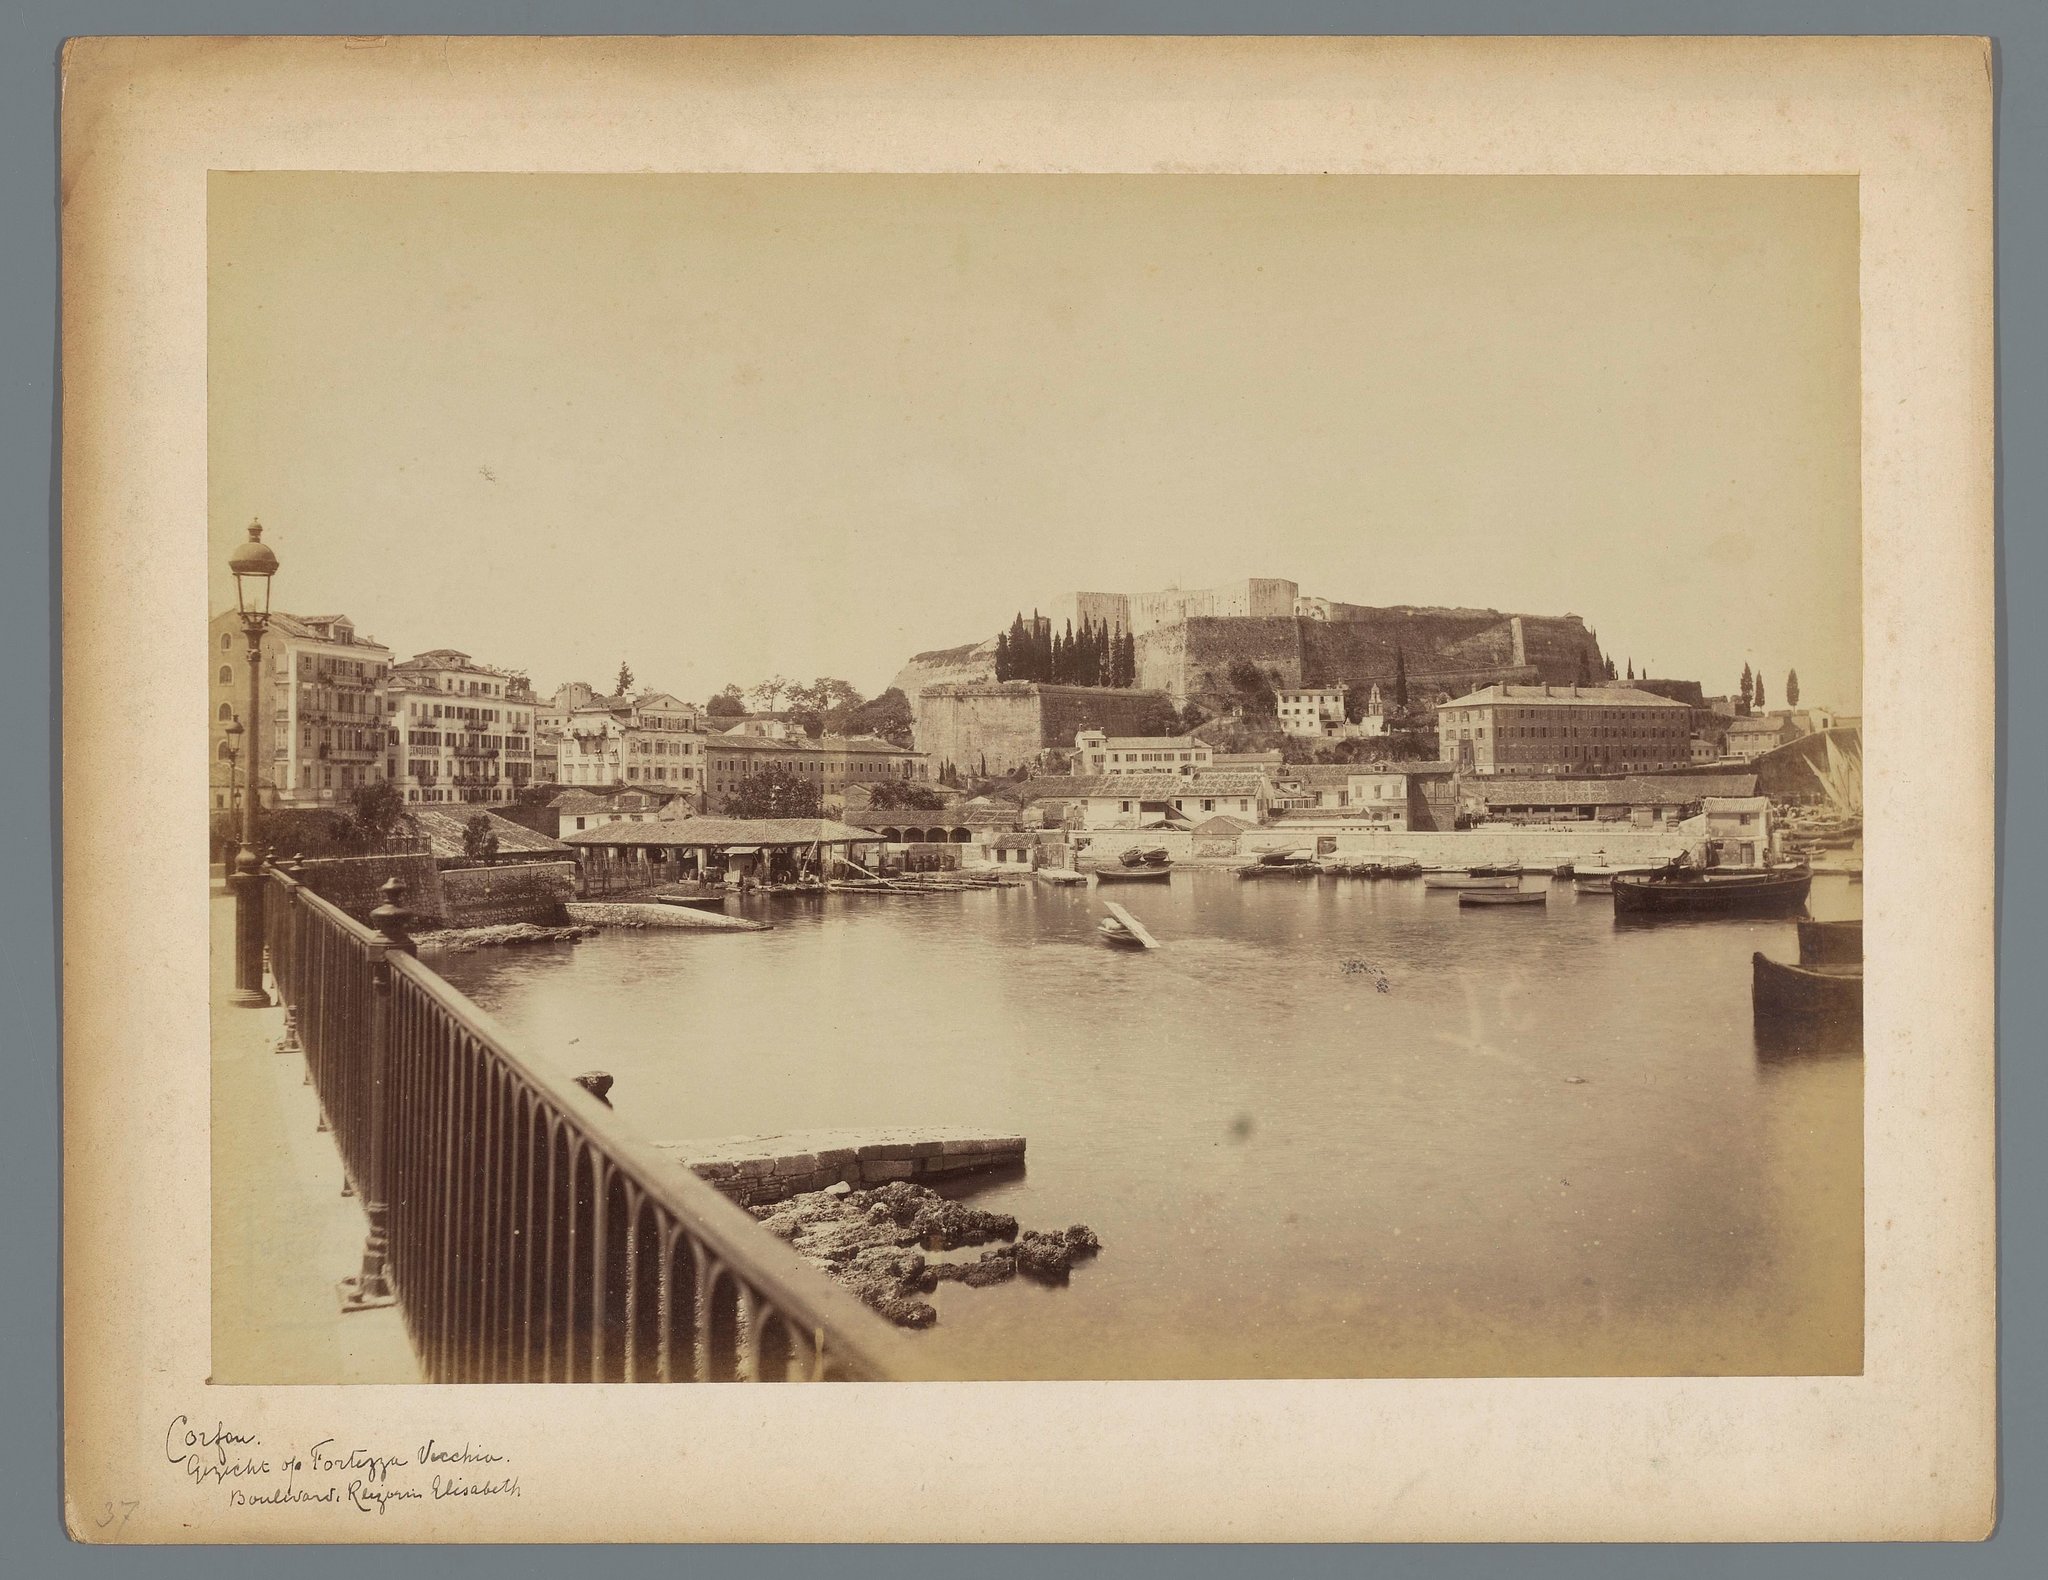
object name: photograph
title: Gezicht op de Nieuwe Vesting in Korfoe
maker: Anonymous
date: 1860-1900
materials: cardboard, paper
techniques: albumen print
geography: corfu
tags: fortress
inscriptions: number: ‘1900’